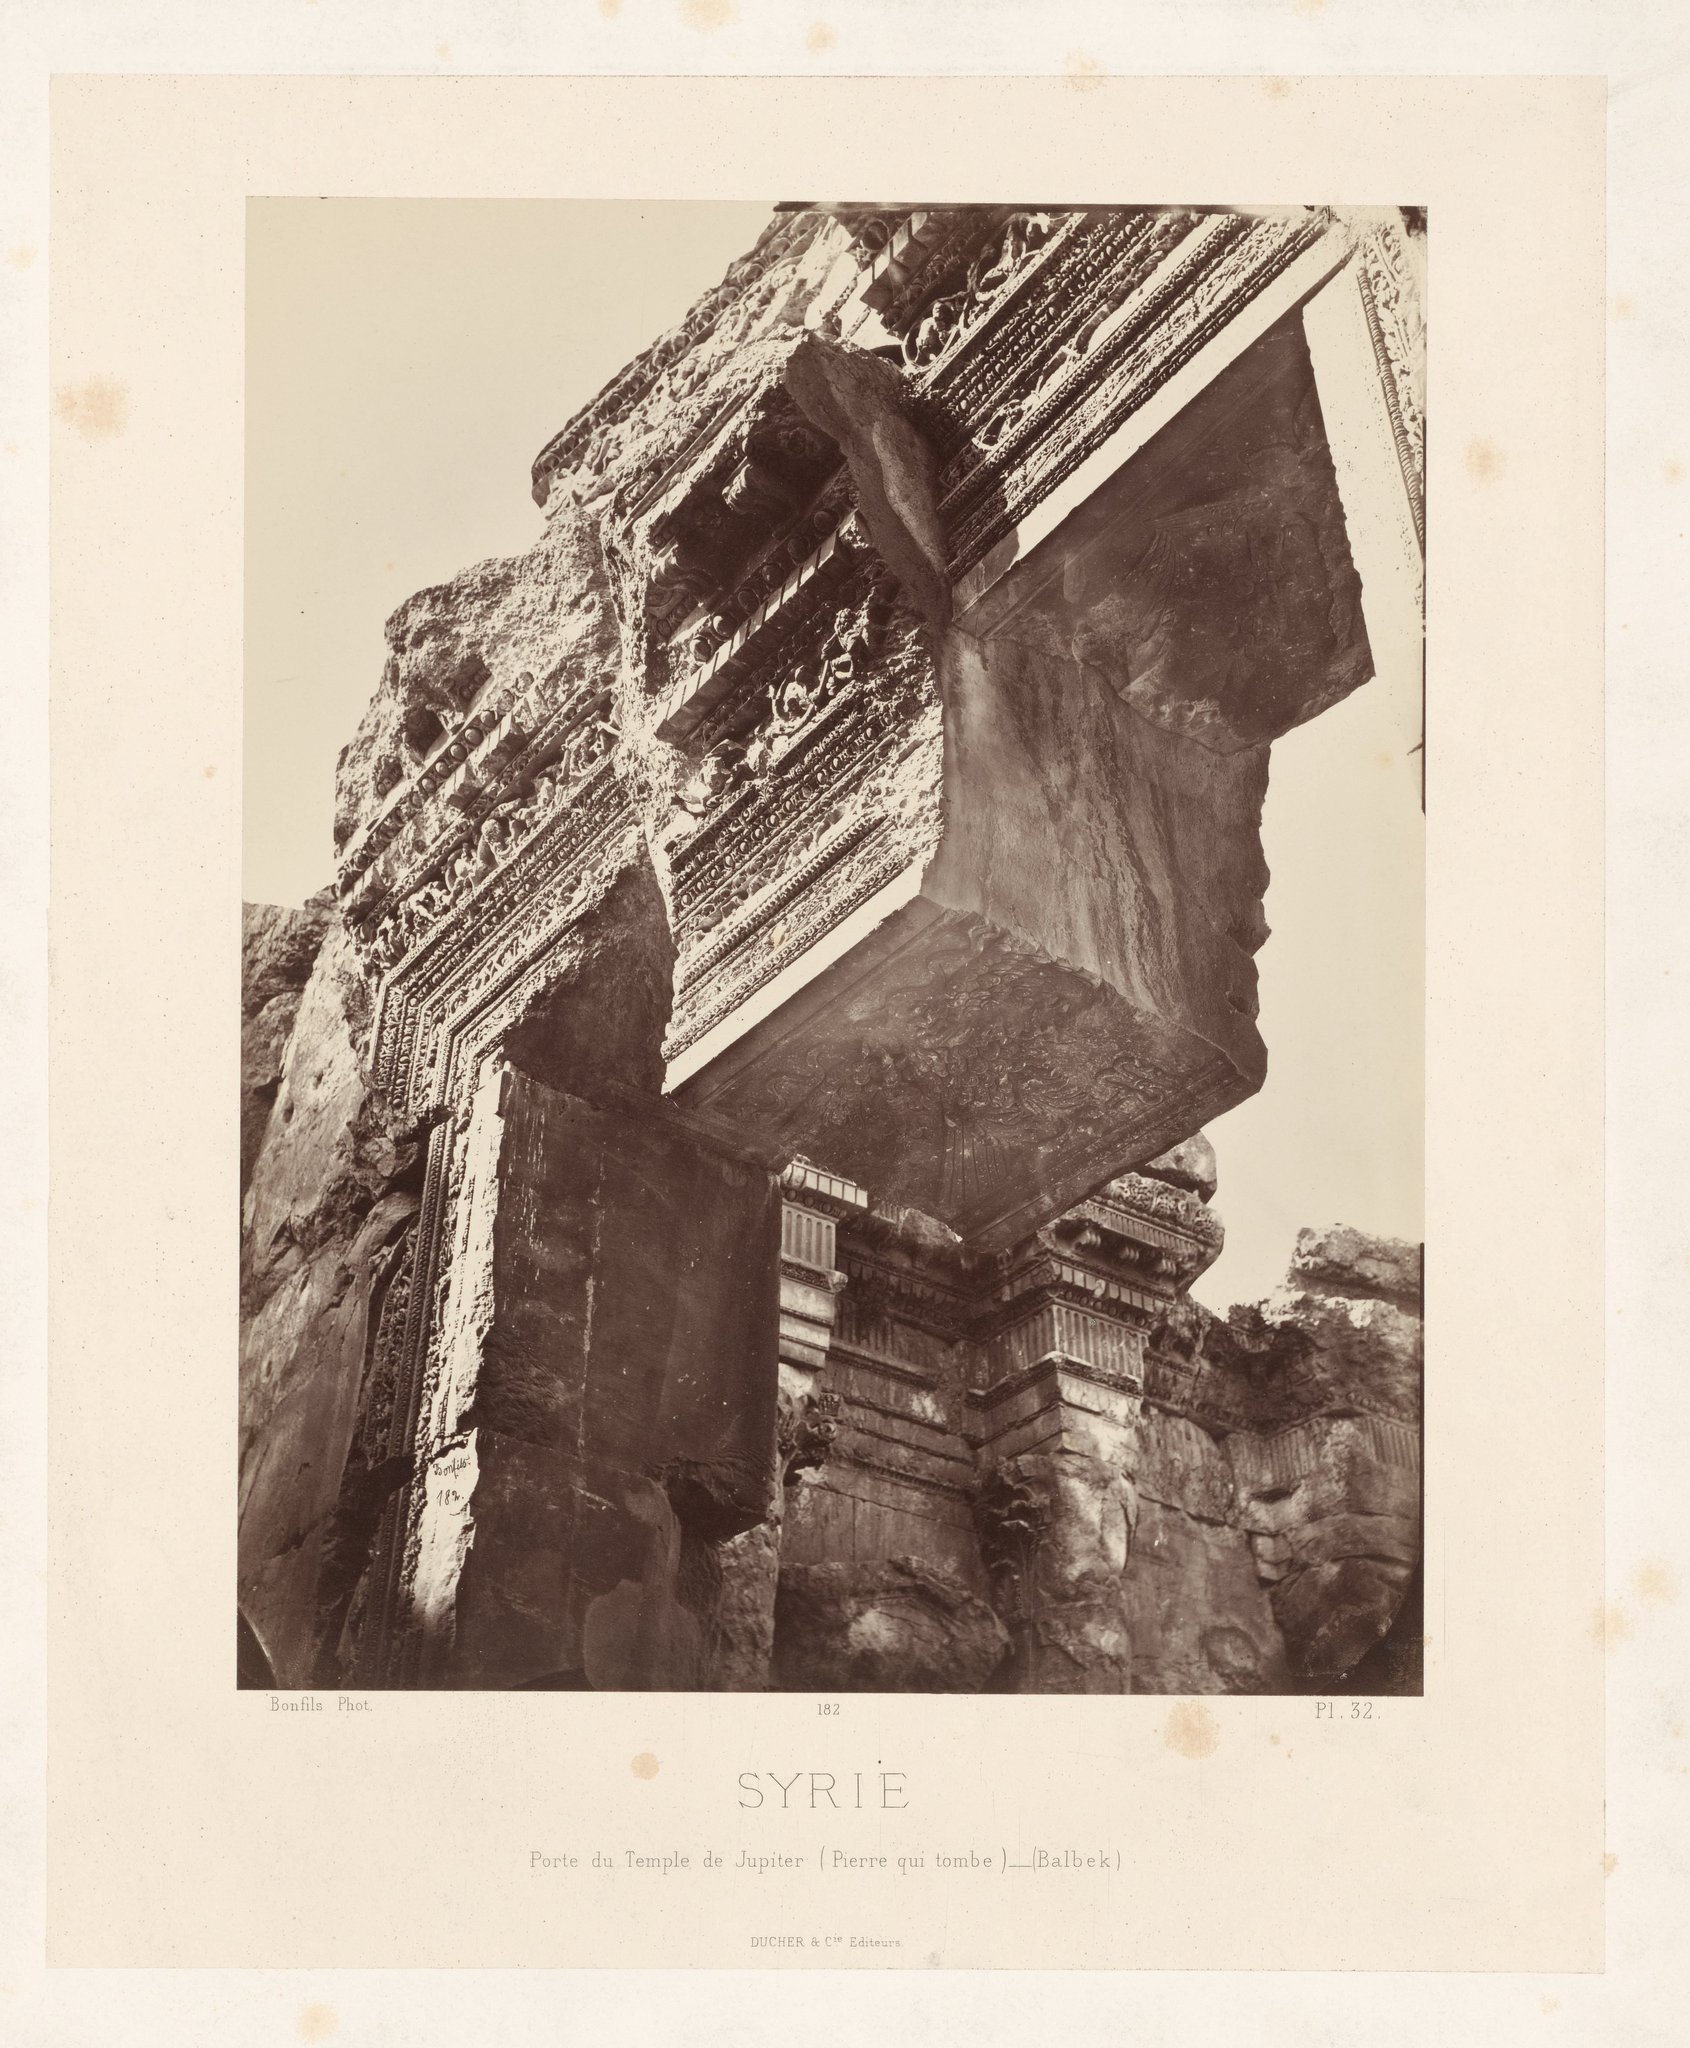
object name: photograph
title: Gezicht op de collonade in het midden van de tempel van Luxor, Egypte (Egypte/Temple de Louksor, Vue générale des colonnades du milieu (Thèbes)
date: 1872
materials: cardboard, paper, photographic support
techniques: albumen print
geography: baalbek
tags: luxor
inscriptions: signature: ‘Bonfils Phot.’, number: ‘182’, stamp: ‘Rijksschool voor Kunstnijverheid groep’, number: ‘Pl. 32’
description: Syrie/Porte du Temple de Jupiter (Pierre qui tombe)- (Balbek) Pl. 32.